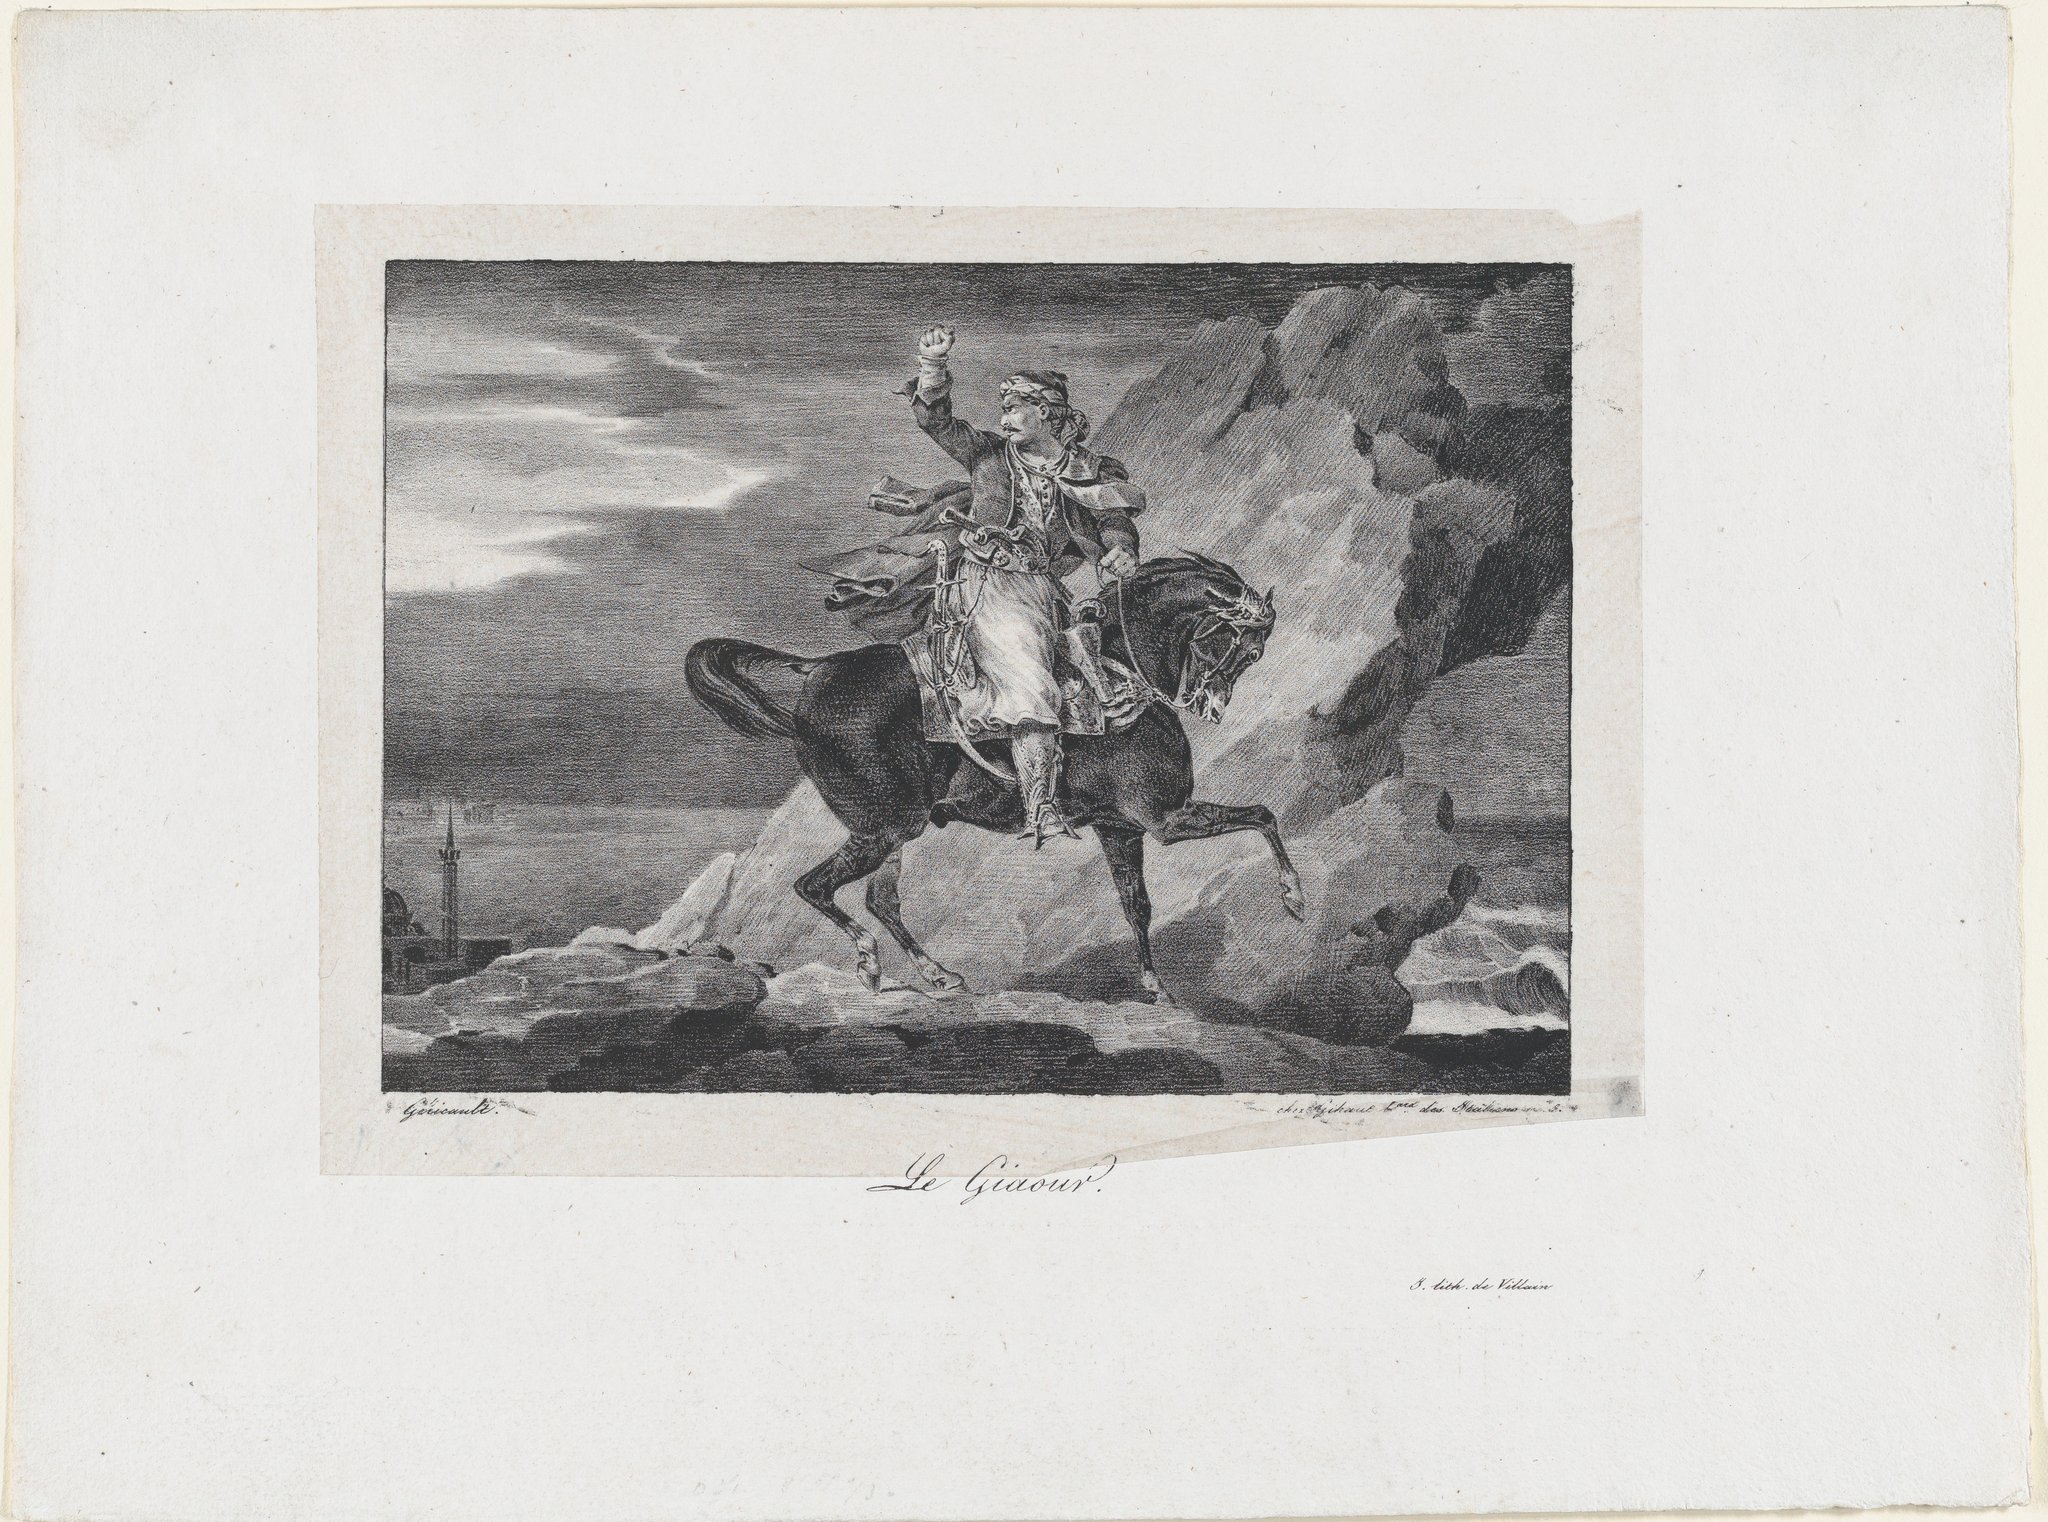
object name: print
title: The Giaour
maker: jean louis andré théodore géricault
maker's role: artist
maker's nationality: french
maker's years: 1791-1824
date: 1820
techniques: printmaking, lithograph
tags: men,horses